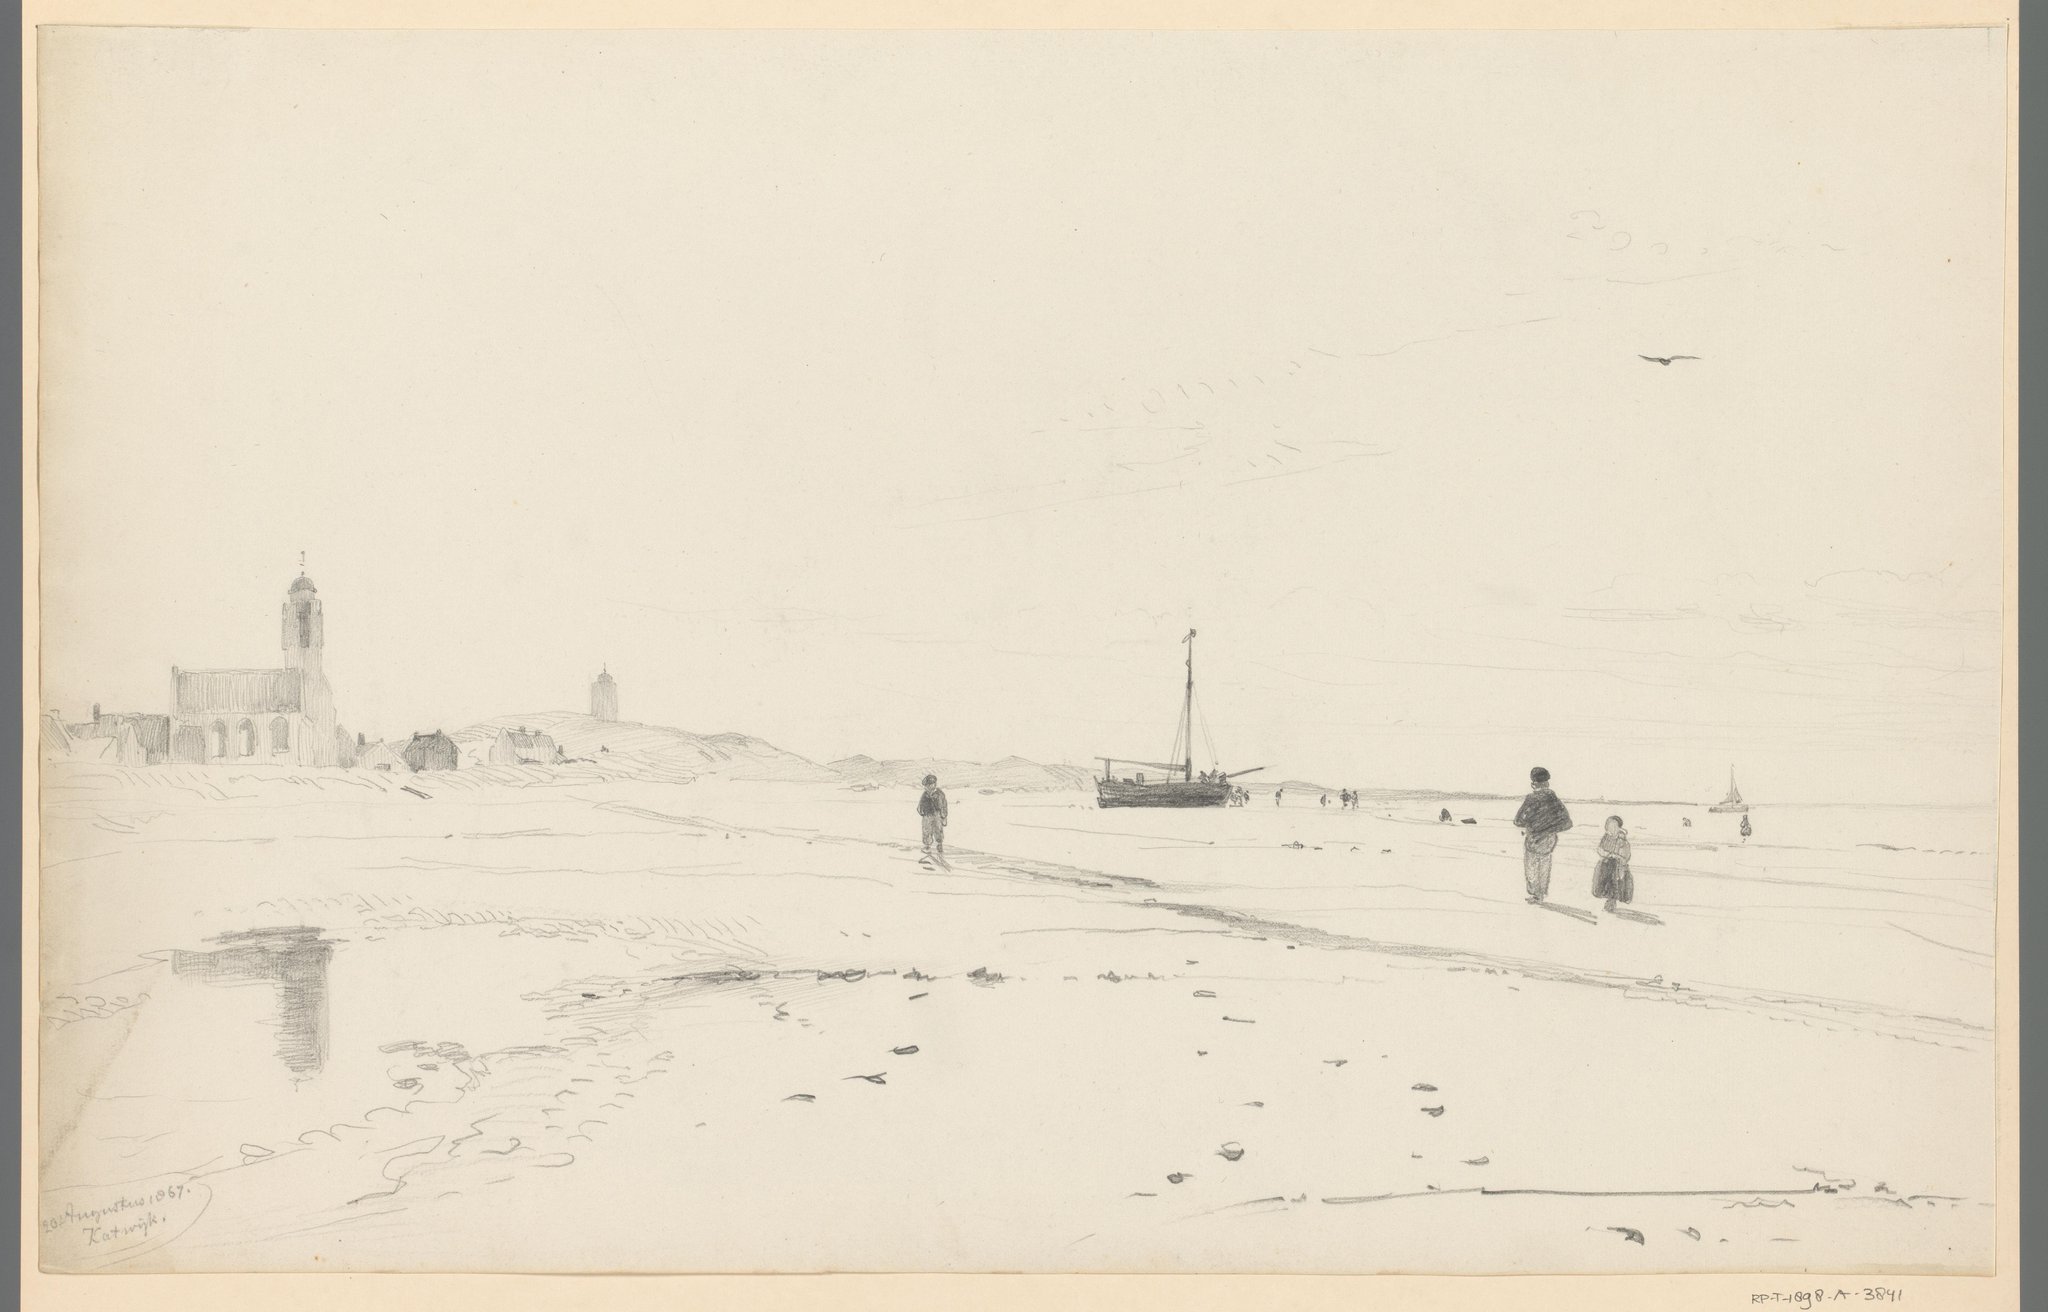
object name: drawing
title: Op het strand van Katwijk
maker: willem anthonie van deventer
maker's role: draughtsman, painter, print maker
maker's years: 1824-1893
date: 1867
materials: paper, pencil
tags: church (exterior), beach